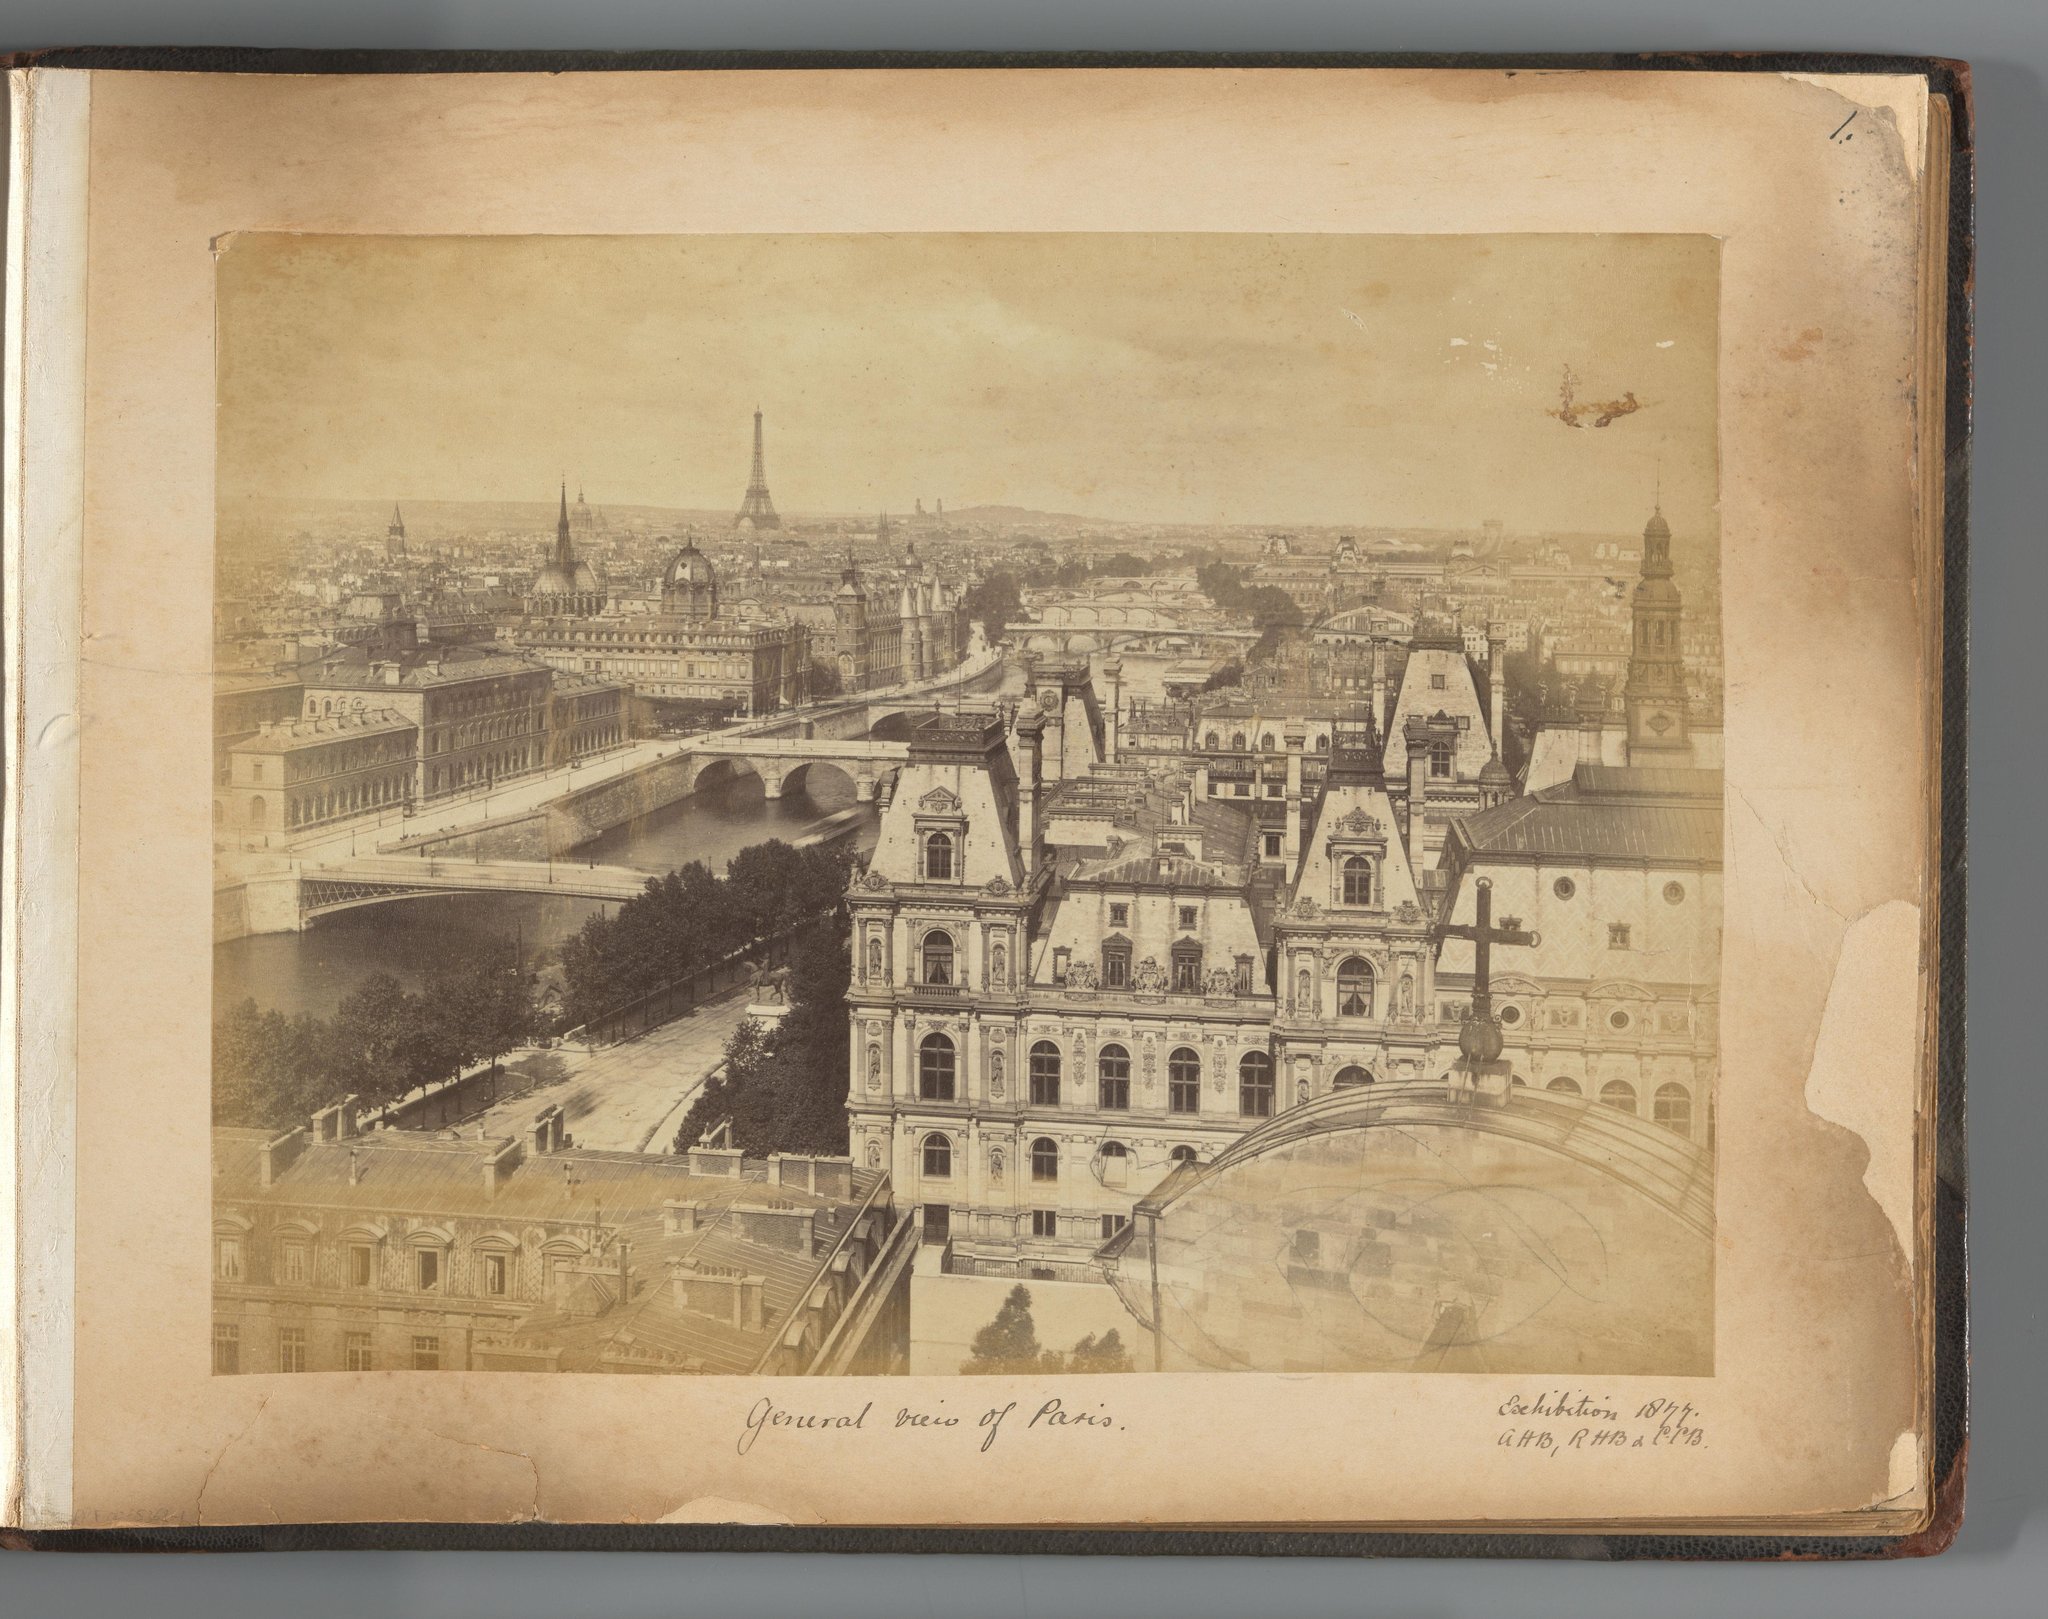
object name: album leaf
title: General view of Paris. Exhibition 1877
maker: c.c. blackburn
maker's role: fotograaf, luitenant-kolonel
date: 1877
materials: paper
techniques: albumen print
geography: paris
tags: city-view in general; 'veduta', paris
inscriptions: inscription: ‘AHB, RHB & CCB.’